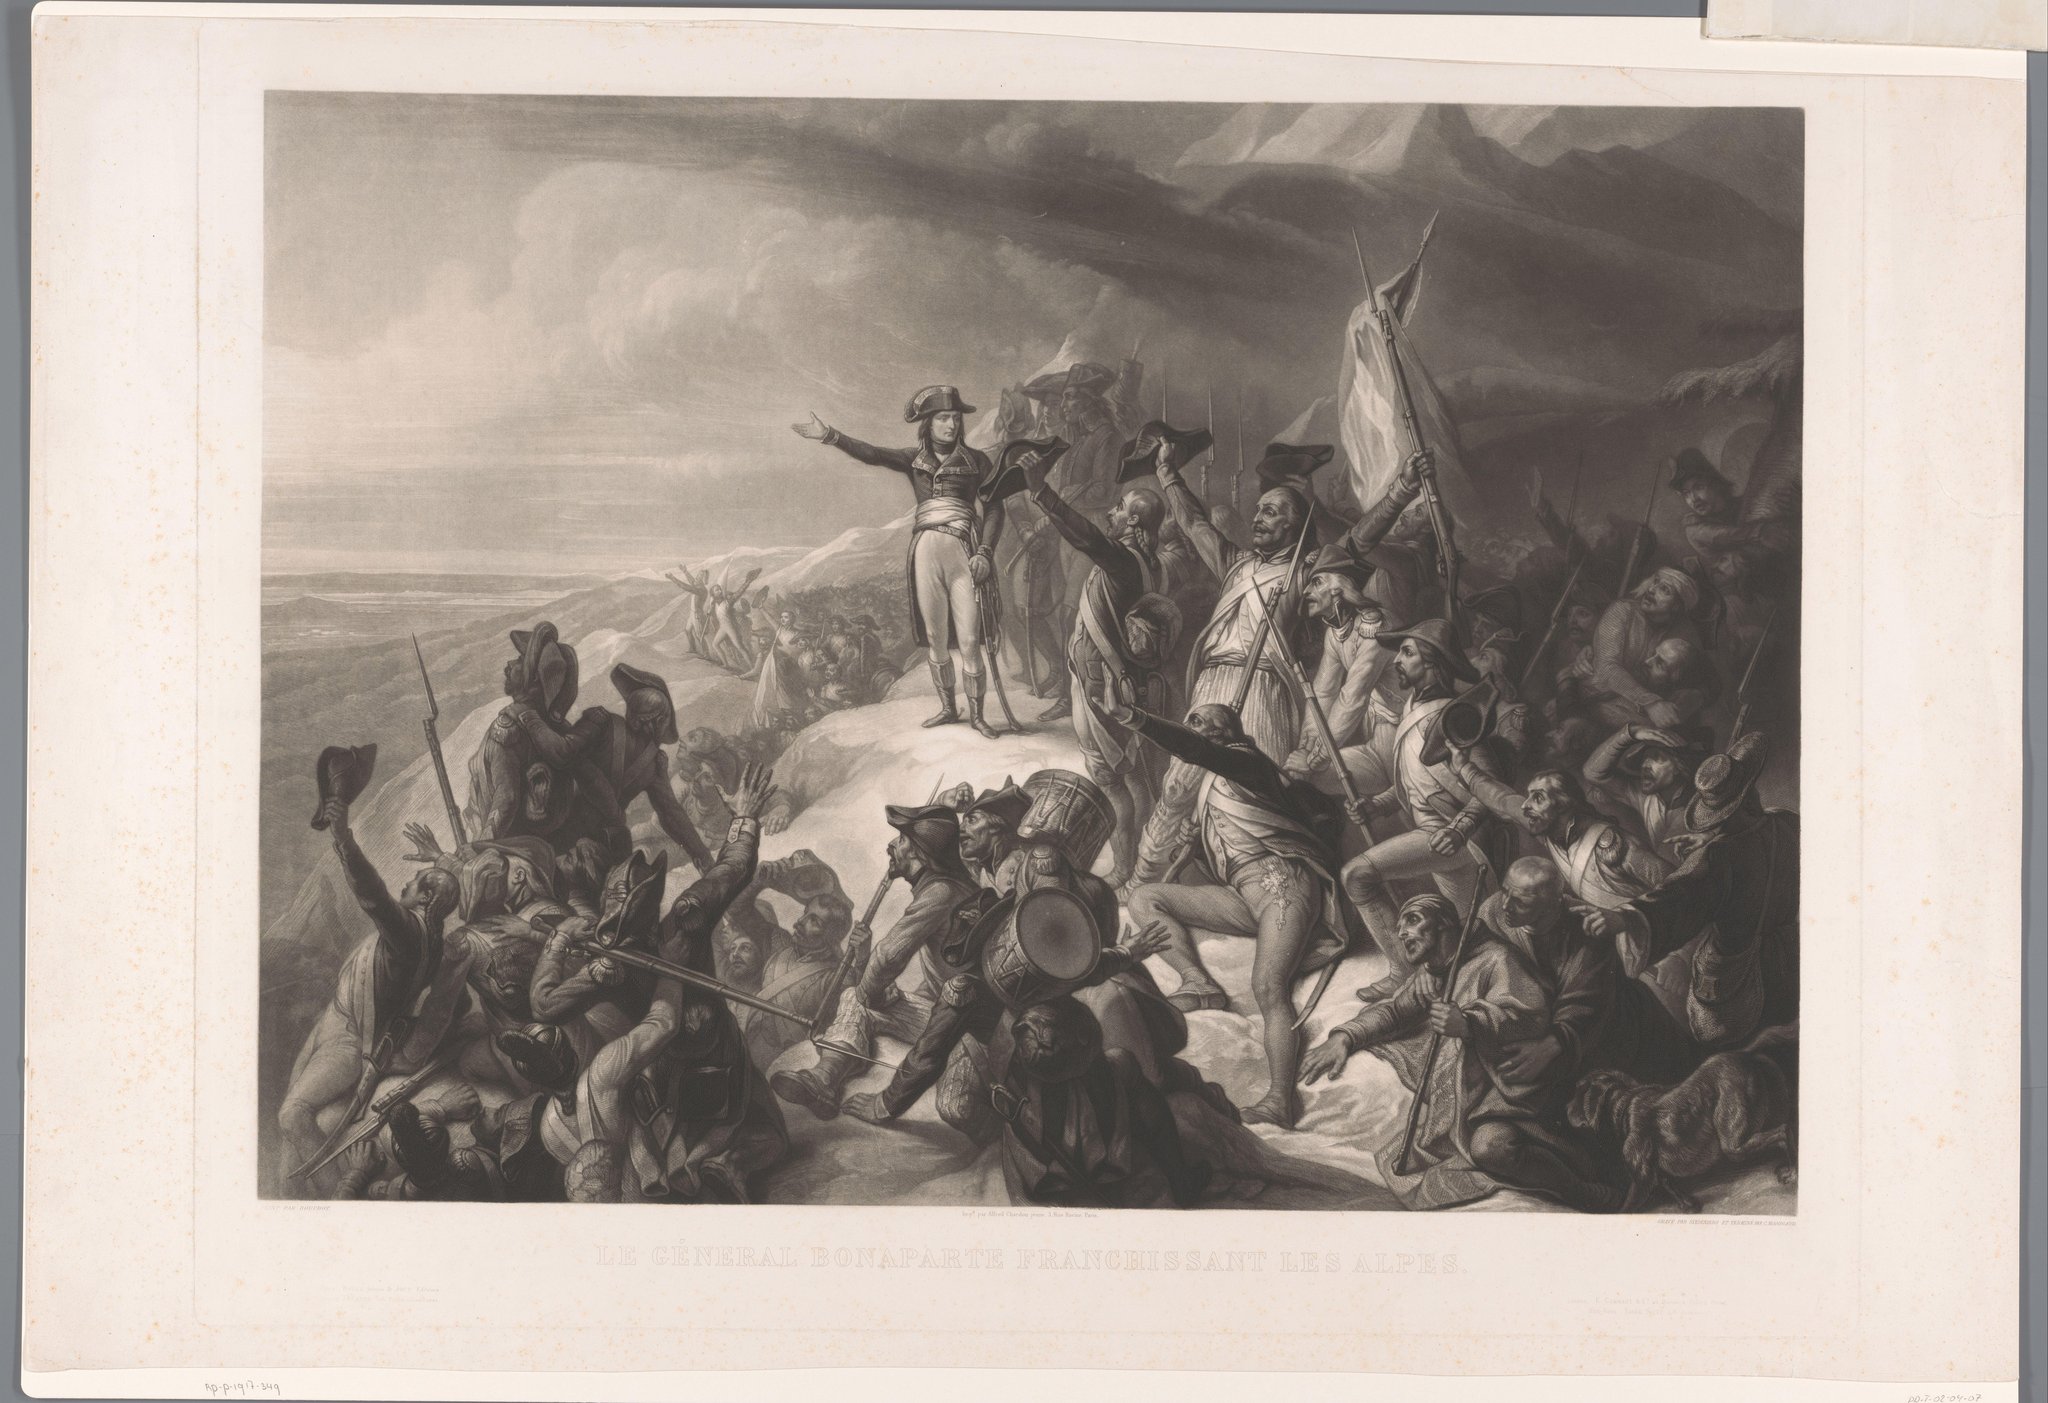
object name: print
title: Napoleon Bonapartes overtocht over de Alpen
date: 1835-1846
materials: paper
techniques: etching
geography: paris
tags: napoleon i (emperor of the french), army 'en route'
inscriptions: collector's mark: Lugt 2228